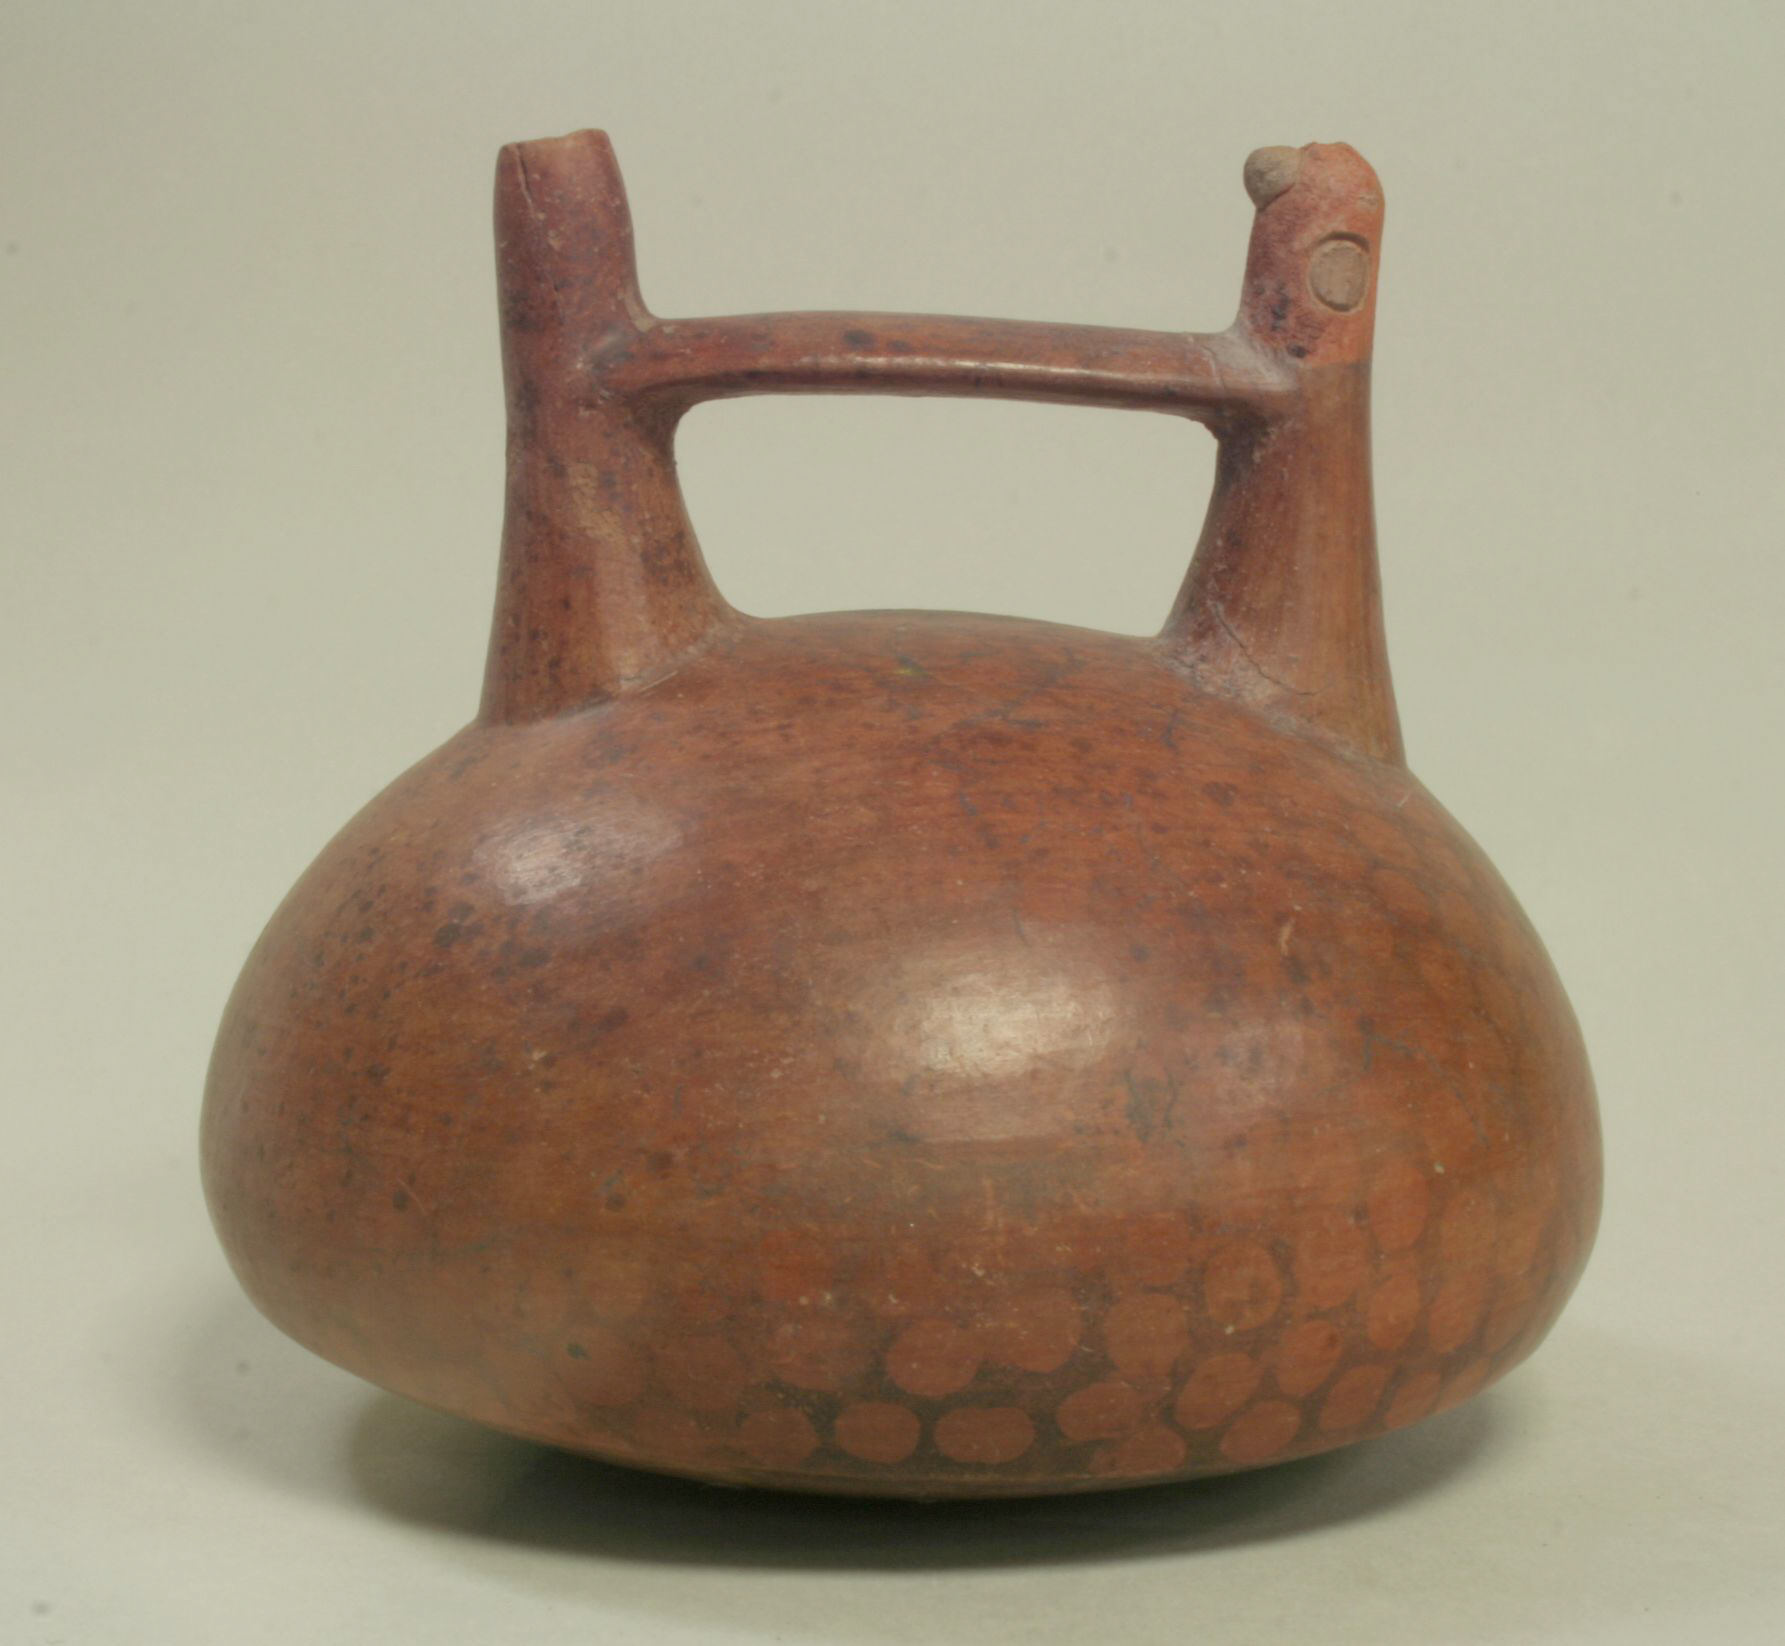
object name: bottle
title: Double Spout and Bridge Bottle with Bird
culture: paracas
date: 500-101 BCE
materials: ceramic, pigment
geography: peru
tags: birds